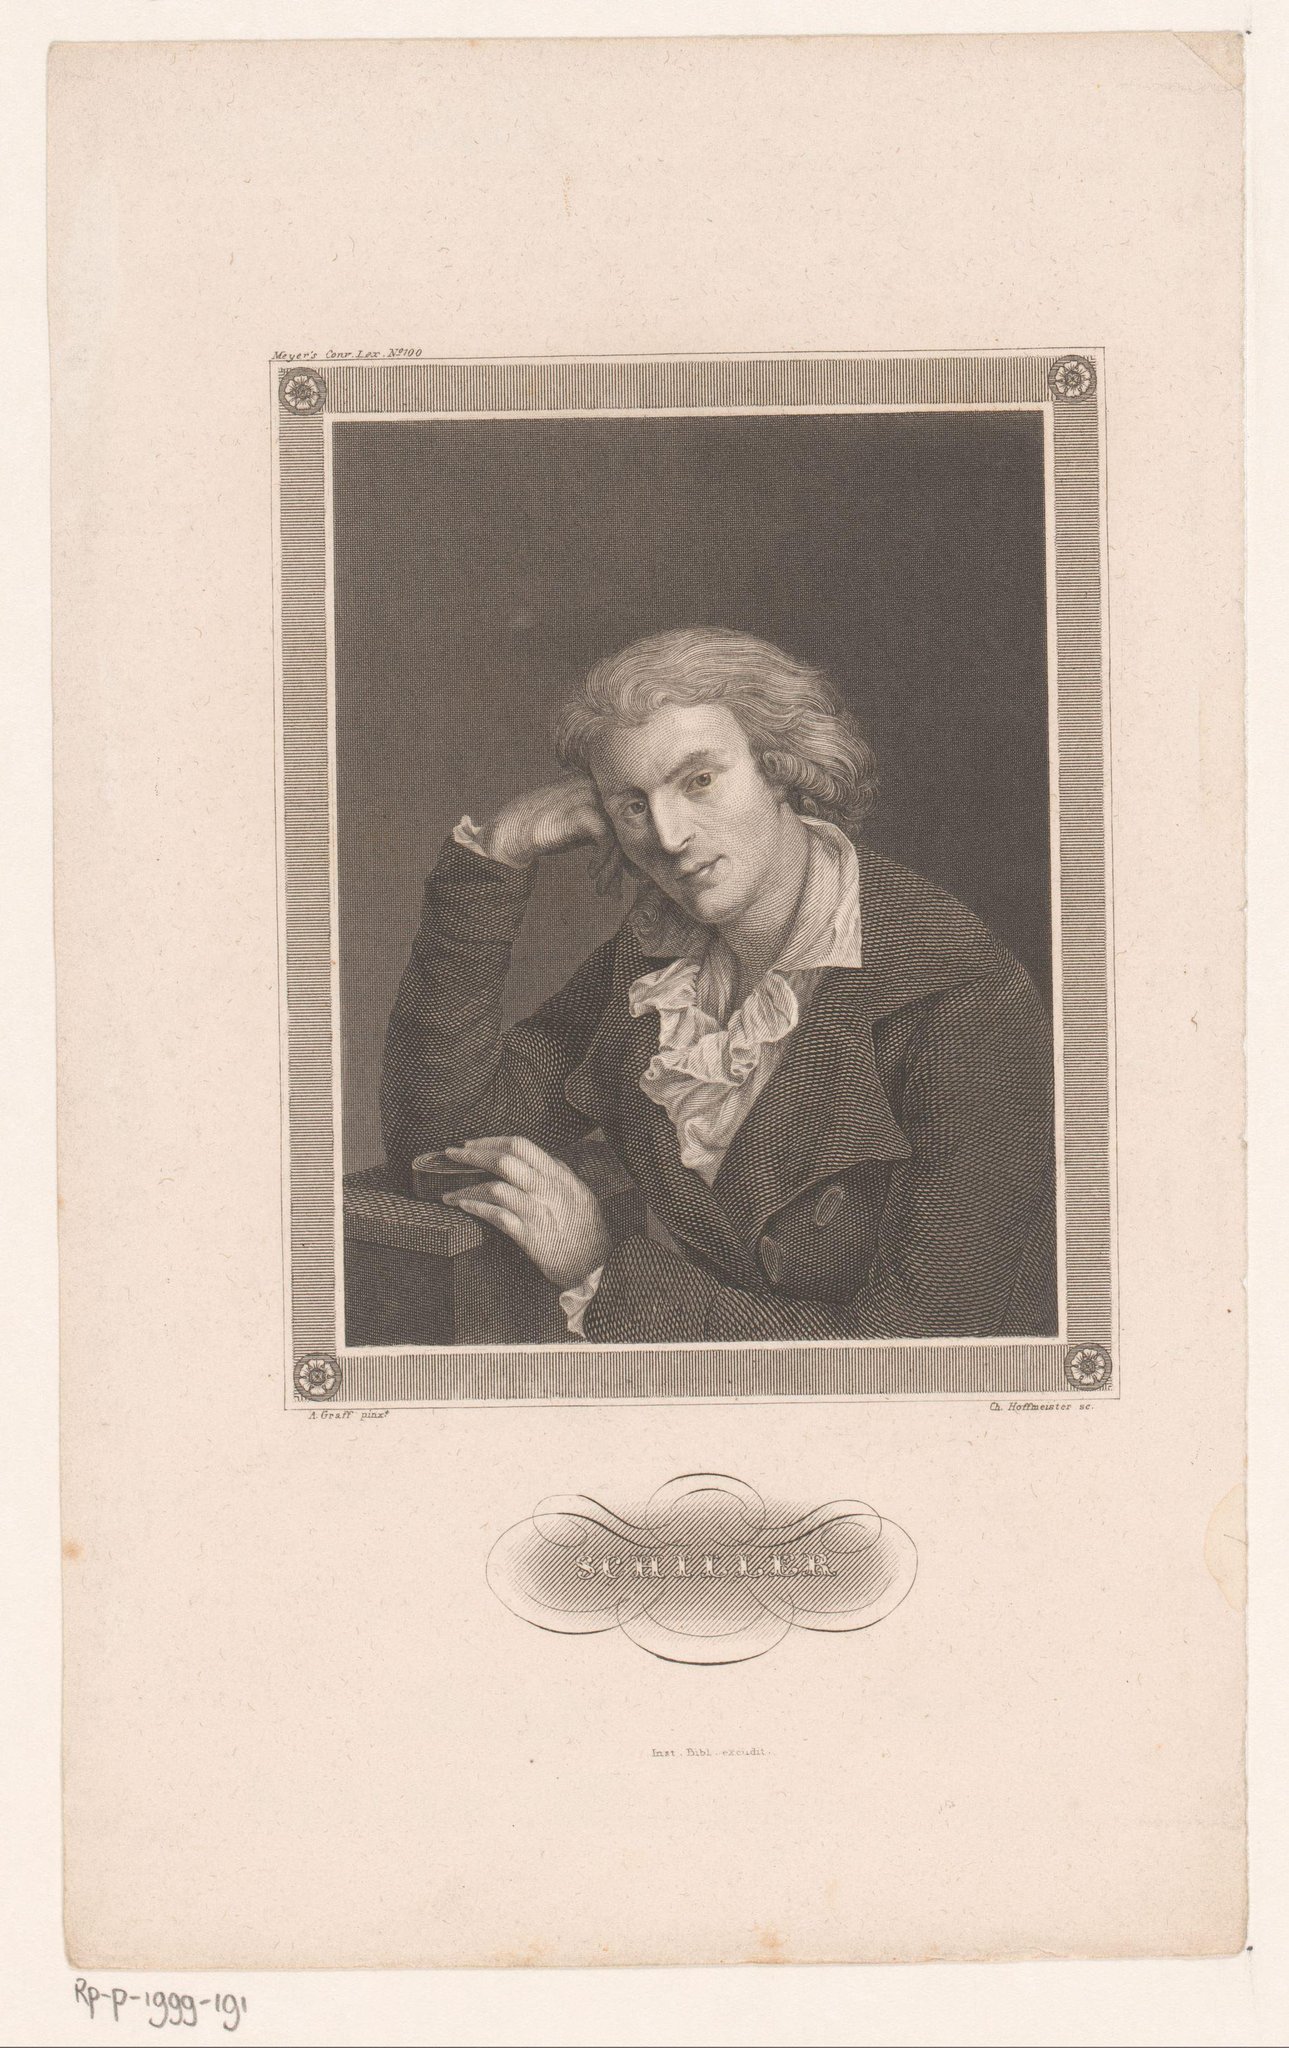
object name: book illustration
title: Portret van Friedrich von Schiller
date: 1840-1855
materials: paper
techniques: engraving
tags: friedrich von schiller, historical persons, writer, poet, author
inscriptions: collector's mark: Lugt 2760, collector's mark: Lugt 2228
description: Prent afkomstig uit: Conversations-Lexikon für die gebildeten Stände, voor het eerst uitgegeven tussen 1840-1855.